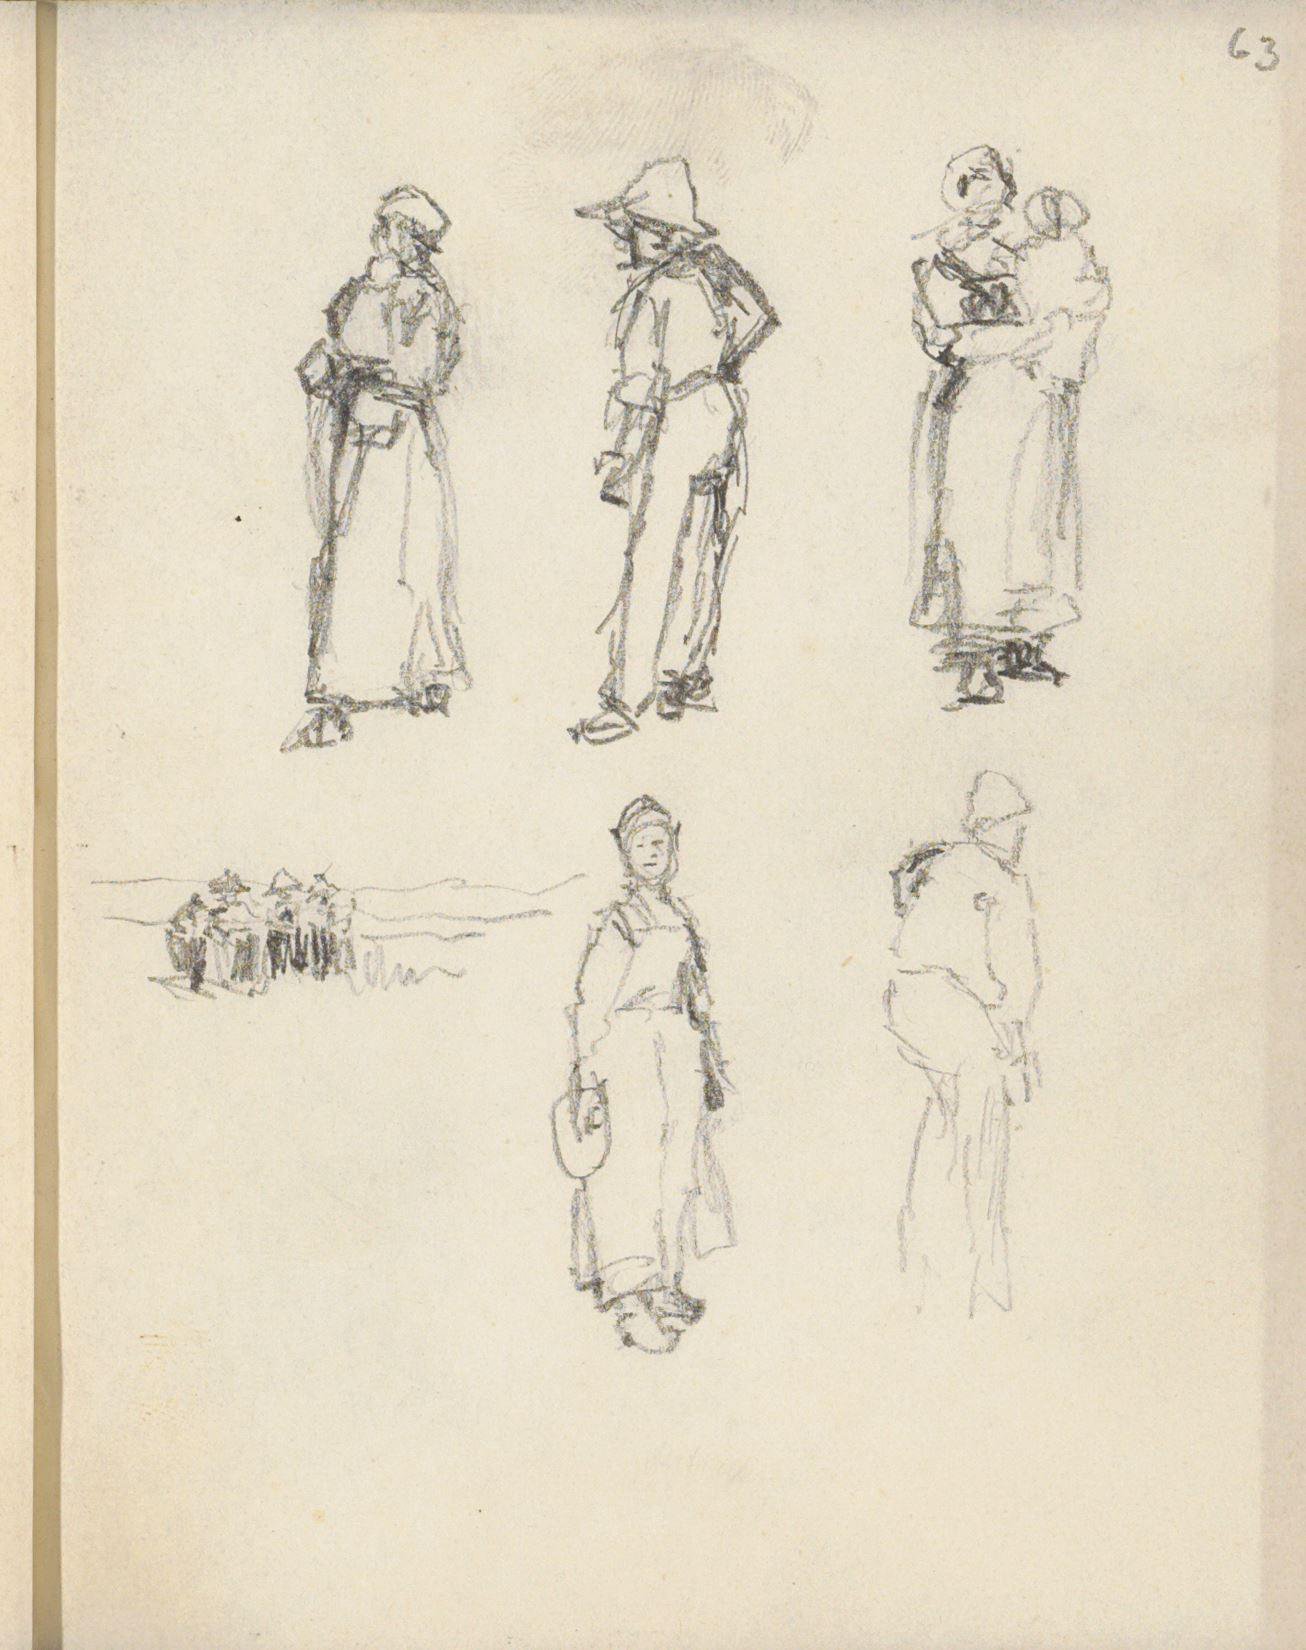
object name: sketchbook leaf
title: Figuurstudies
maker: alfred william rich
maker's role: draughtsman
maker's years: 1856-1921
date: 1892-1893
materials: paper, pencil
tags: anatomy (non-medical)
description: Blad 63 recto uit een schetsboek met 86 bladen.